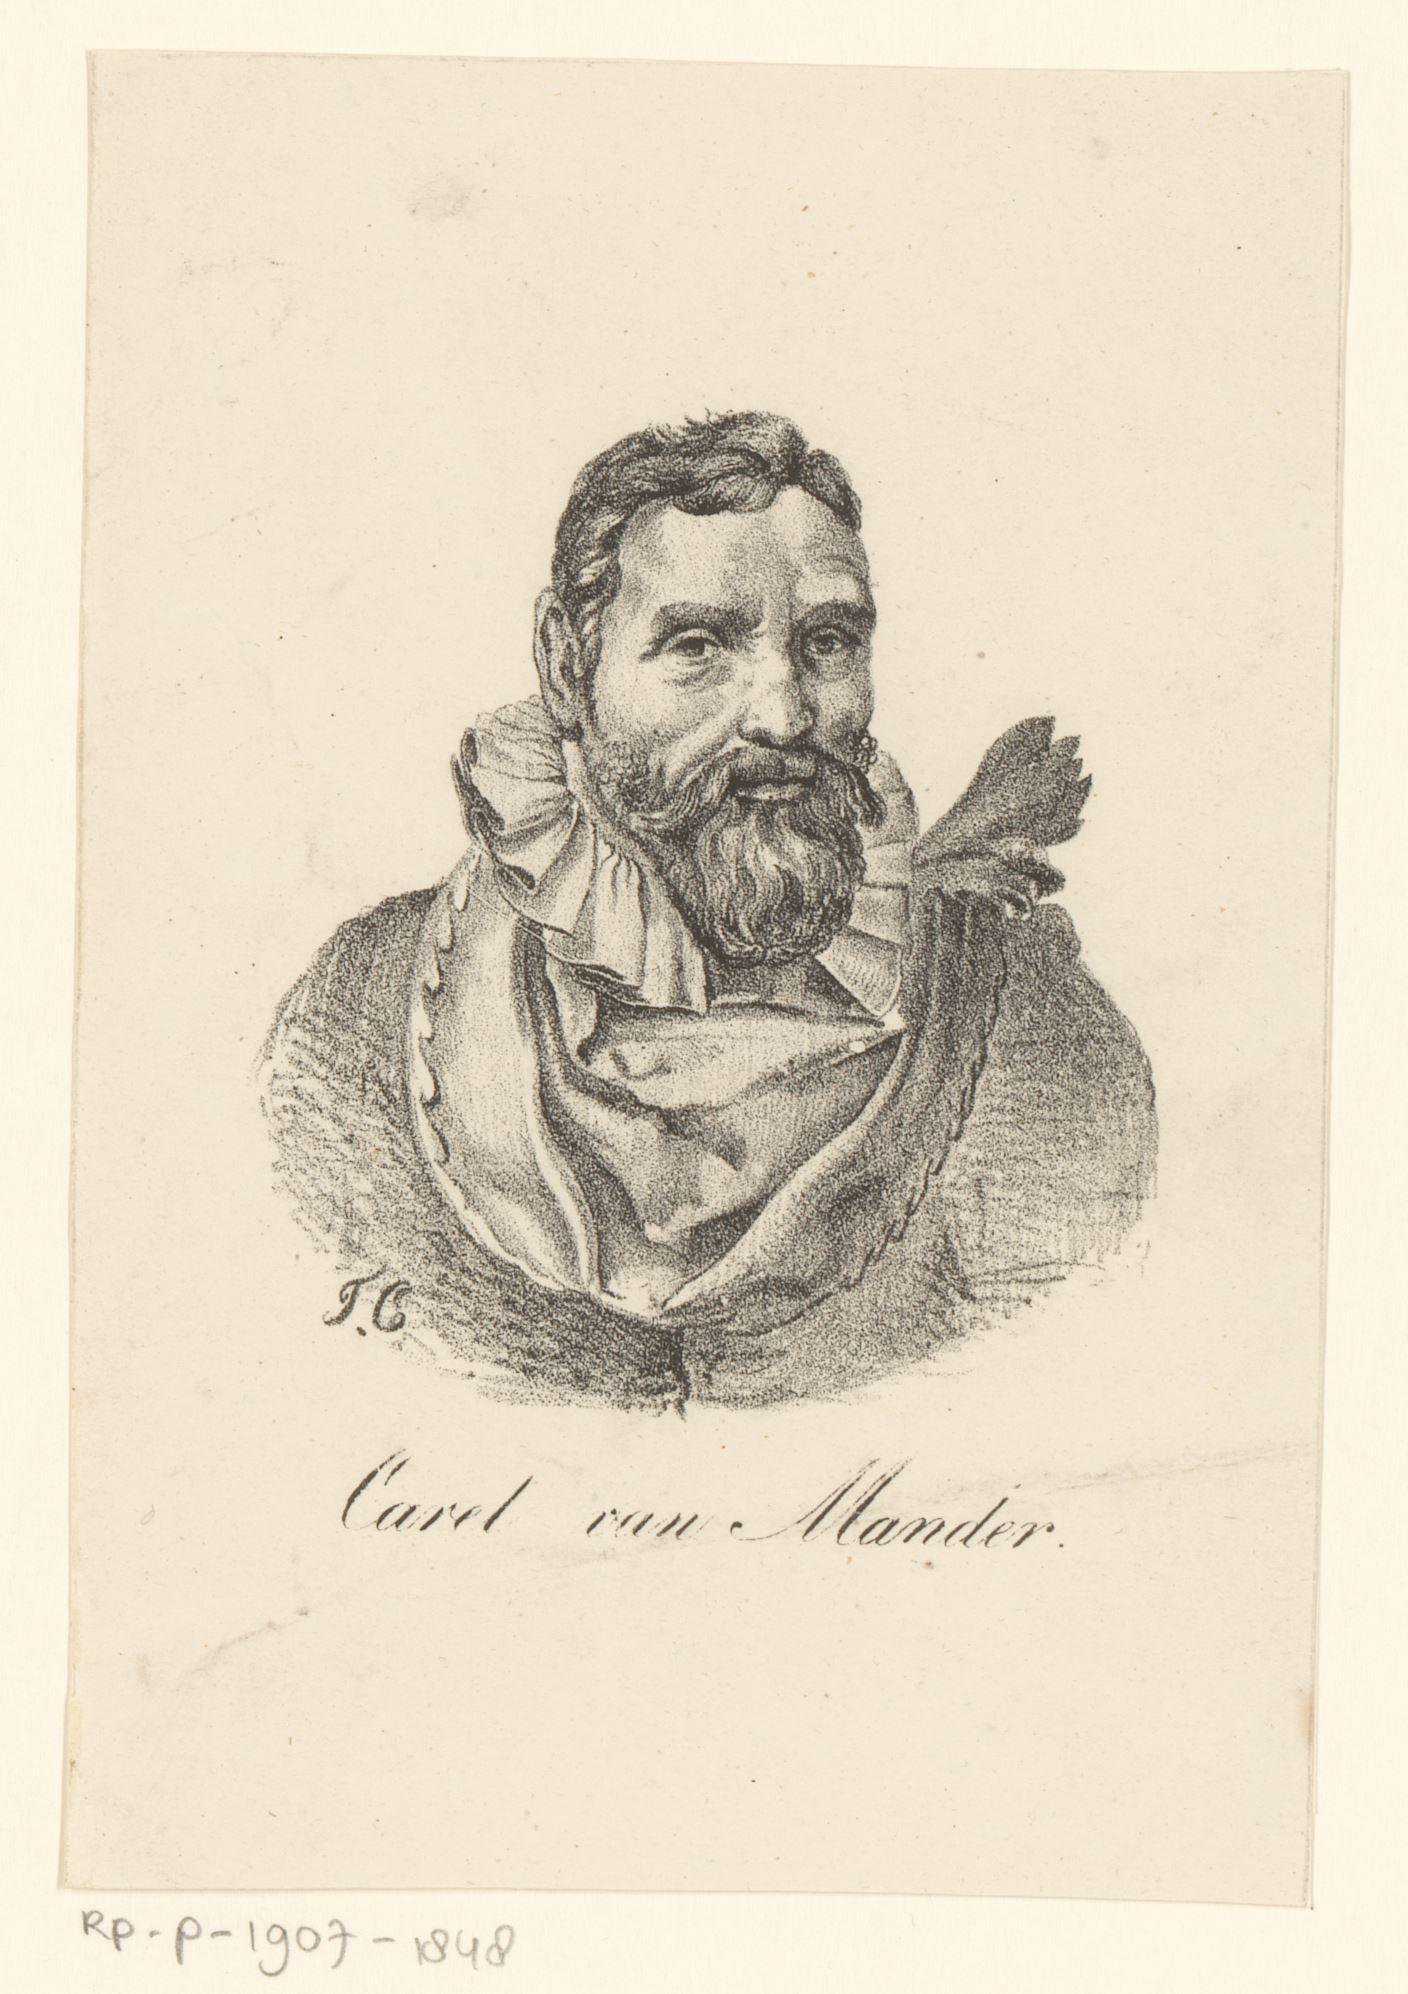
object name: print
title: Portret van Carel van Mander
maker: Anonymous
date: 1809-1853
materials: paper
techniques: lithograph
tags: amsterdam, painter, print maker, draughtsman, karel van mander (i), historical persons (+ (full) bust portrait)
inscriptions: collector's mark: Lugt 2228, monogram: ‘T.C.’